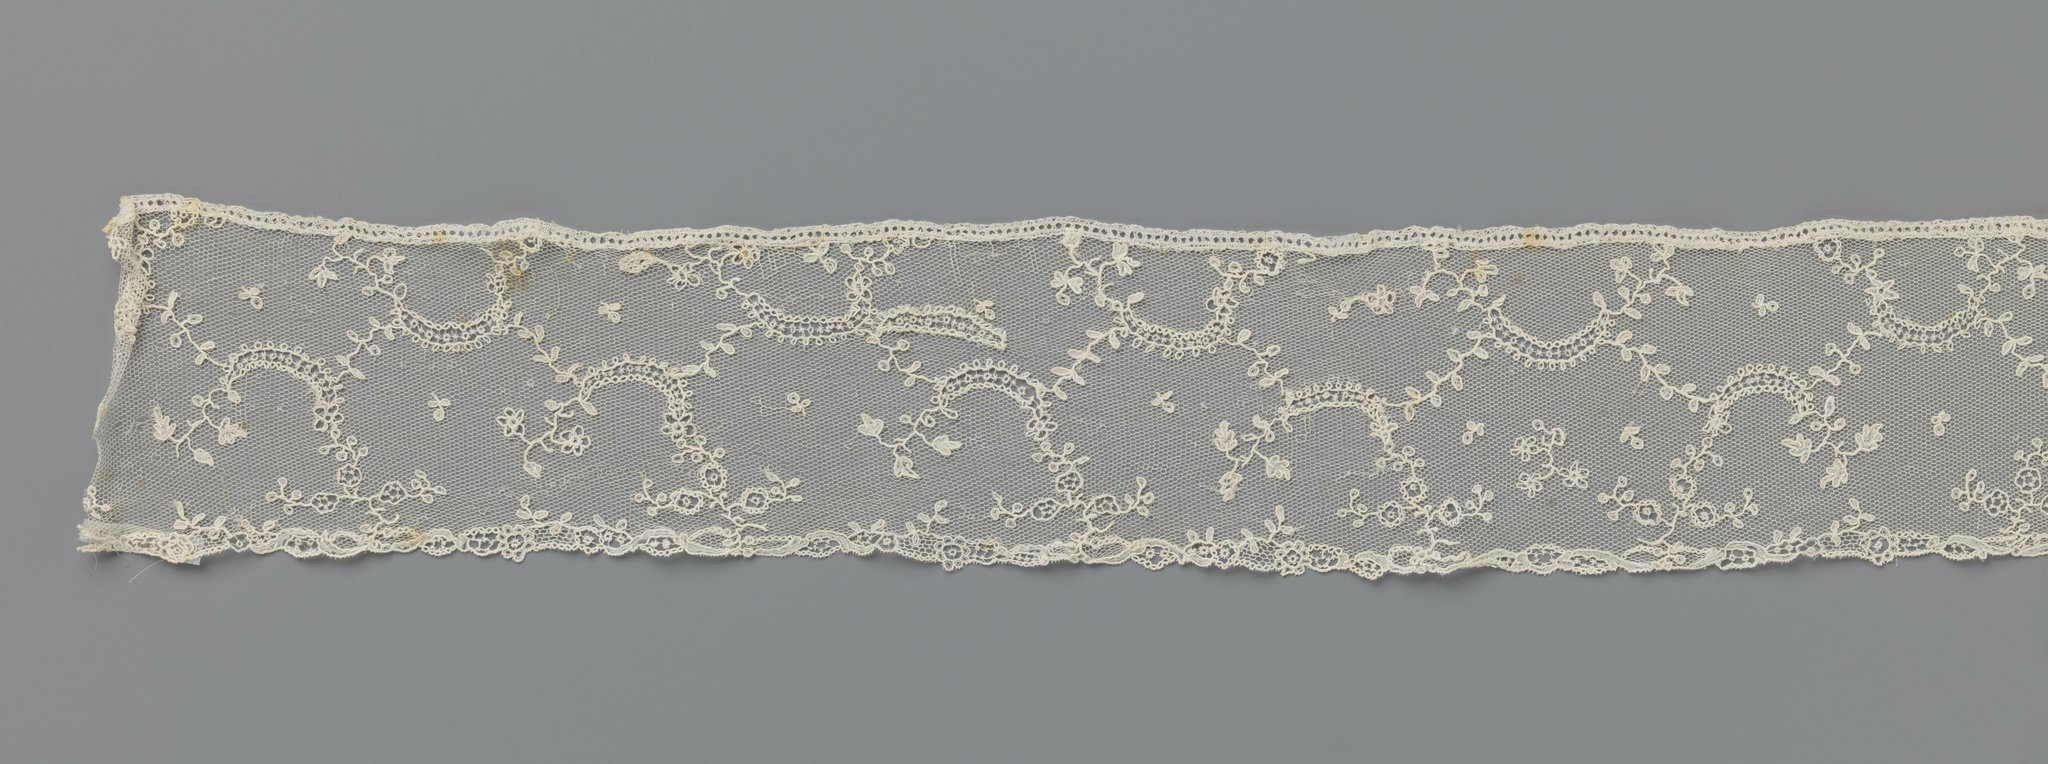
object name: strip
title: Strook applicatiekant met twee rijen aan elkaar geschakelde boogjes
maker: Anonymous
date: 1790-1799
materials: linen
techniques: lace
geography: brussels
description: Strook naturelkleurige Brusselse applicatiekant: naaldkant geappliceerd op drochelgrond. Het zich herhalende patroon bestaat uit twee rijen opengewerkte boogjes, die met ijle rankjes met ovale blaadjes aan elkaar verbonden zijn. De bovenste rij boogjes liggen met de bolle kant naar beneden, de onderste rij boogjes staan met de bolle kant naar boven. Tussen de boogjes door staan gestrooide bloempjes en aan de boogjes zitten kronkelende takjes vast. Het spaarzame volwerk wordt omsloten door wijd gefestoneerde draadbundels. De bovenzijde is afgewerkt met een apart geklost bandje. De vrijwel recht afgewerkte onderzijde is voorzien van zeer fijne picots.